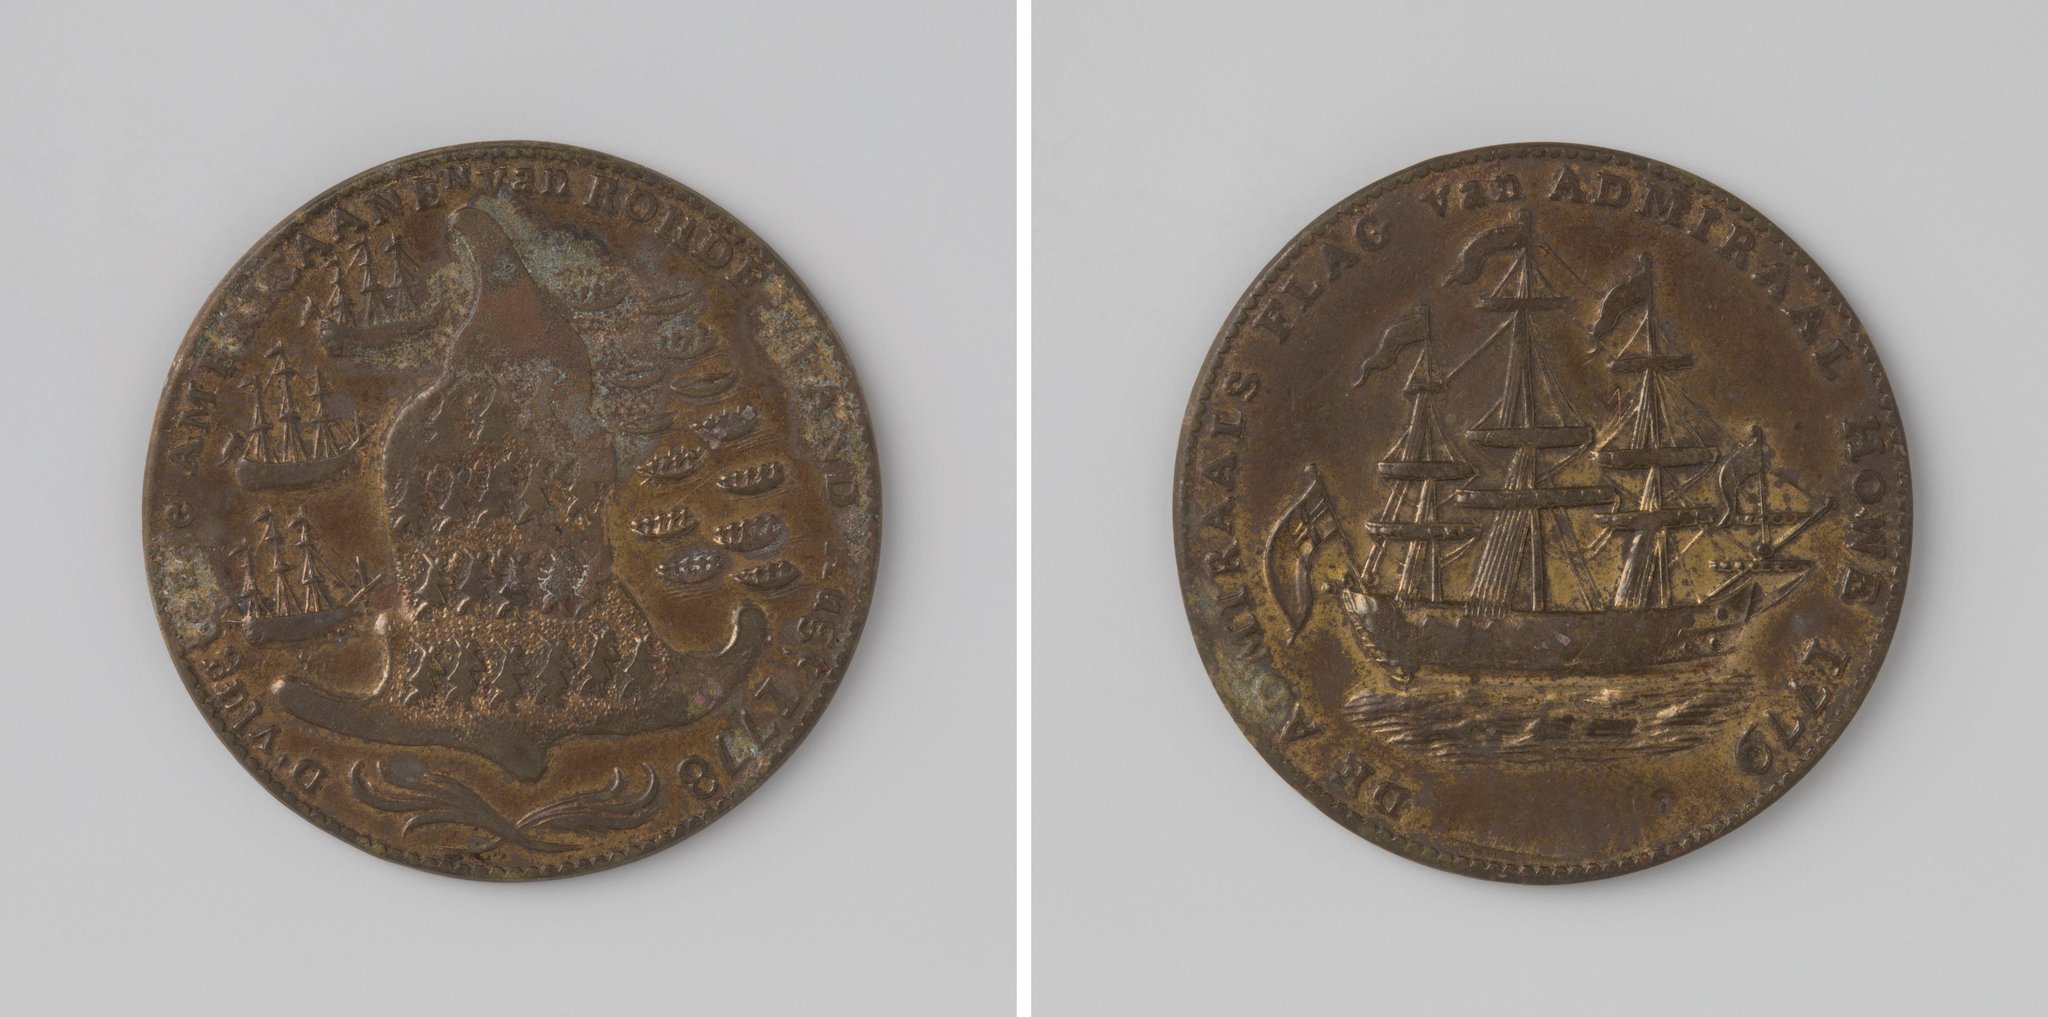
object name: history medal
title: Vlucht van de Amerikaanse rebellen van Rhode Island bij het naderen van de vloot van admiraal William Howe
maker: Anonymous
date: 1779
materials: copper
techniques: striking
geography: england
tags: sir william viscount howe, rhode island, inname van rhode island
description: Koperen penning. Voorzijde: Rhode Island met ter linkerzijde drie oorlogsschepen, en ter rechterzijde de vluchtende opstandelingen in kleine bootjes binnen omschrift. Keerzijde: driemaster binnen omschrift.